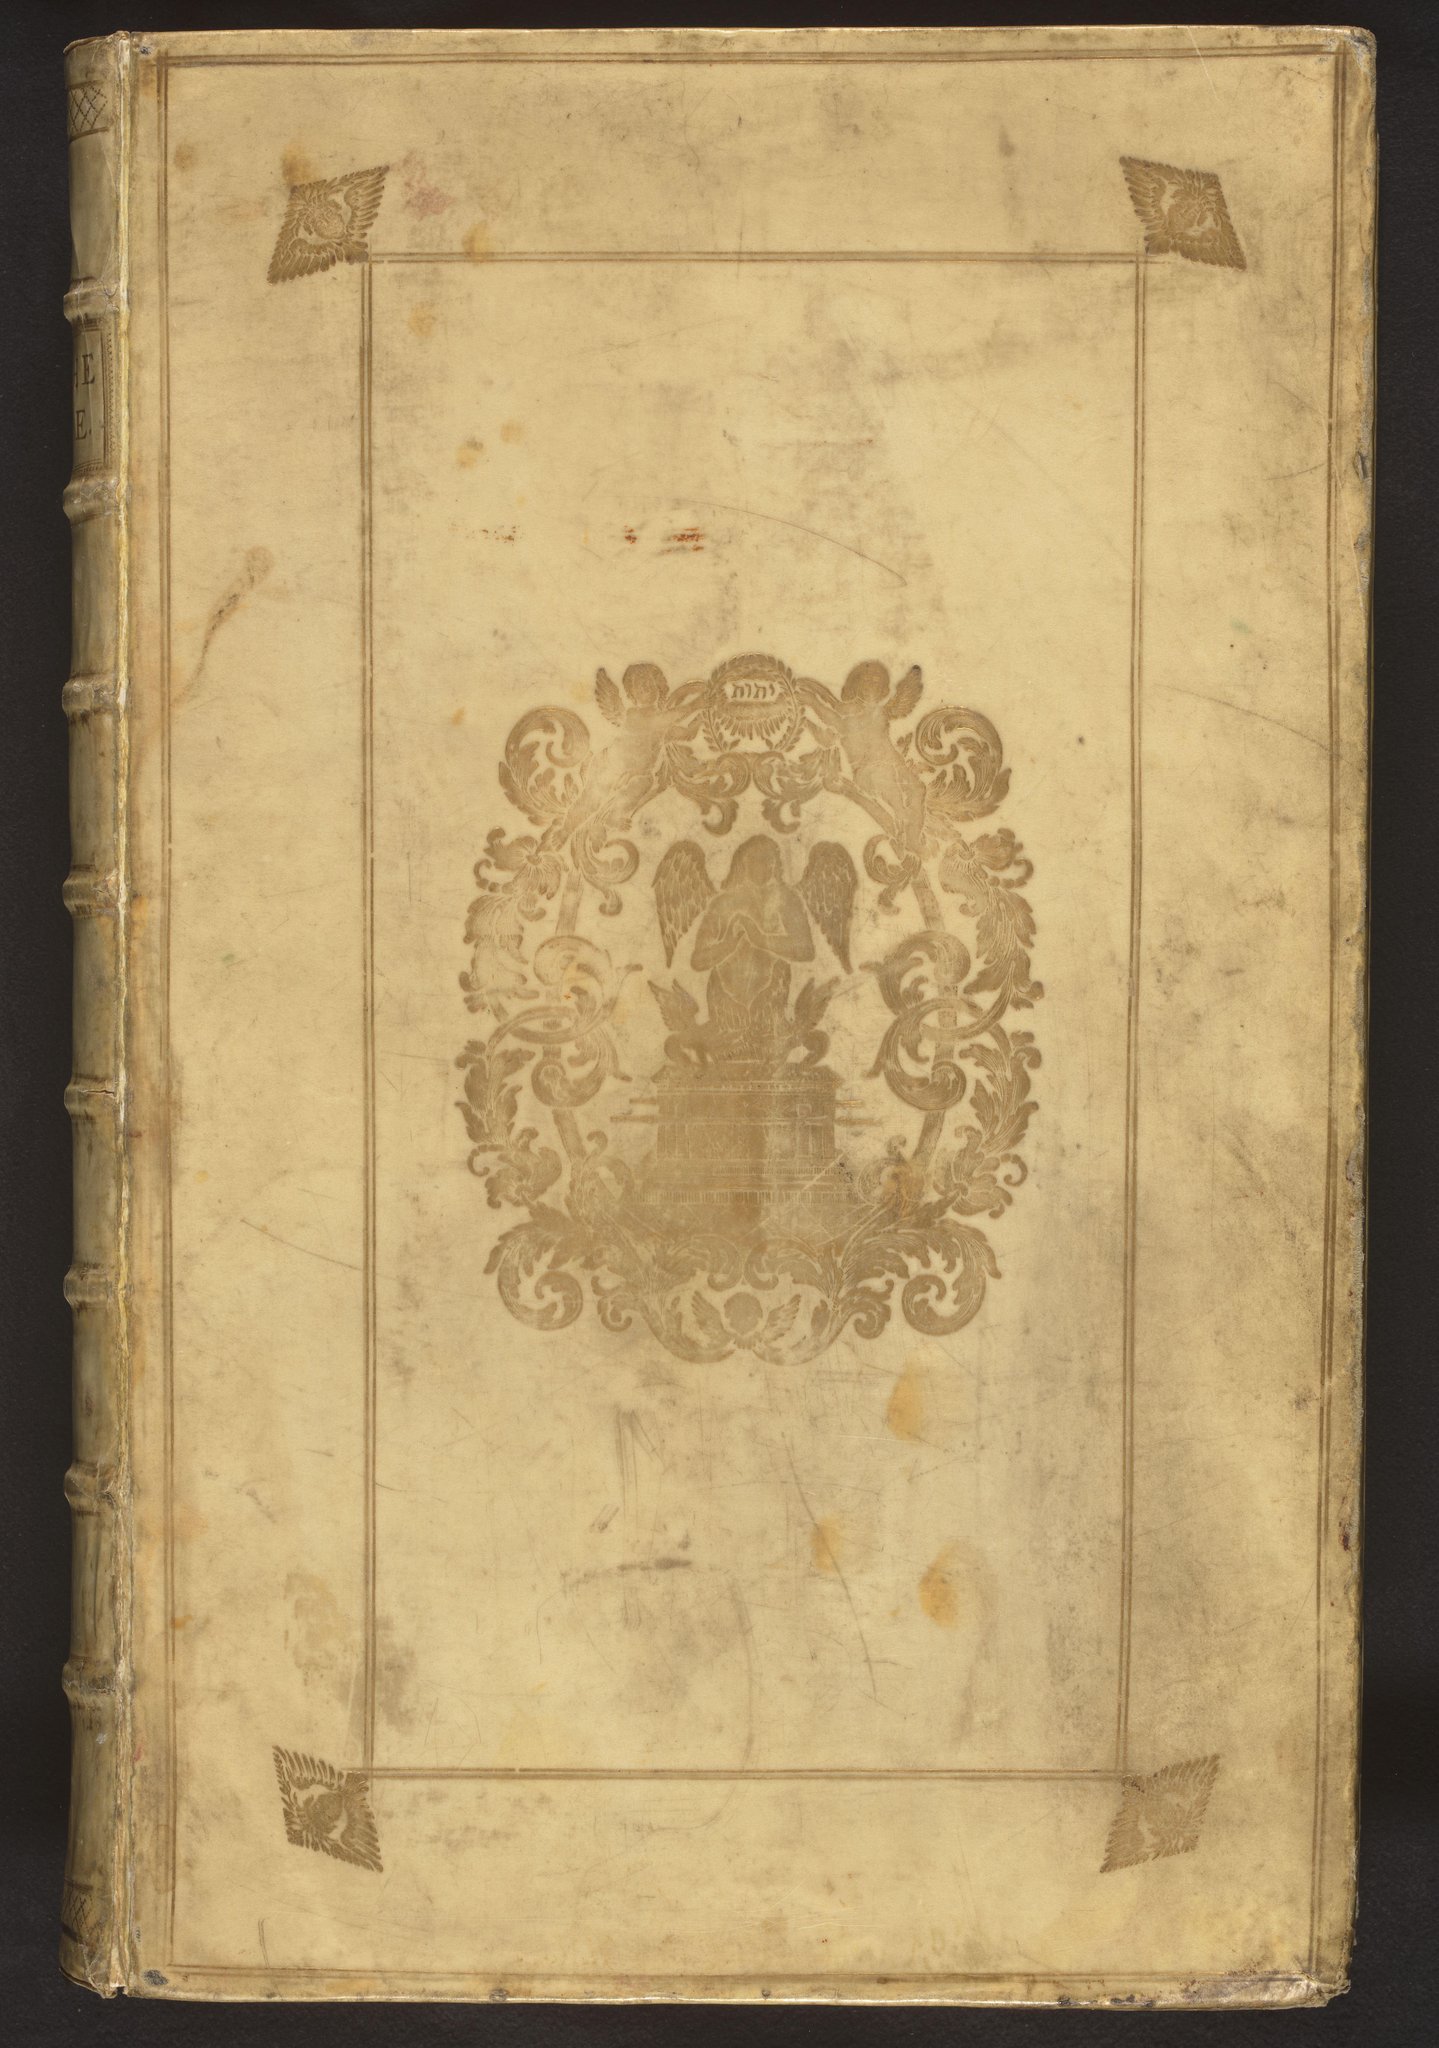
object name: picture bible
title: Historie des Ouden en Nieuwen Testaments ('De Grote Bijbel van Mortier')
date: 1700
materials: paint, gold leaf, ink, paper, parchment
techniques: bookbinding, printing, engraving, etching, hand coloring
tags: ark of the covenant ~ jewish religion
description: Prentbijbel gebonden in vroeg 18de-eeuwse perkamenten banden met goudstempels, uitgegeven door Pieter Mortier, Amsterdam 1700. Op de voor- en achterkant gestempeld een voorstelling van een engel bij het het ark des verbonds. Eerste band met het Oude Testament.